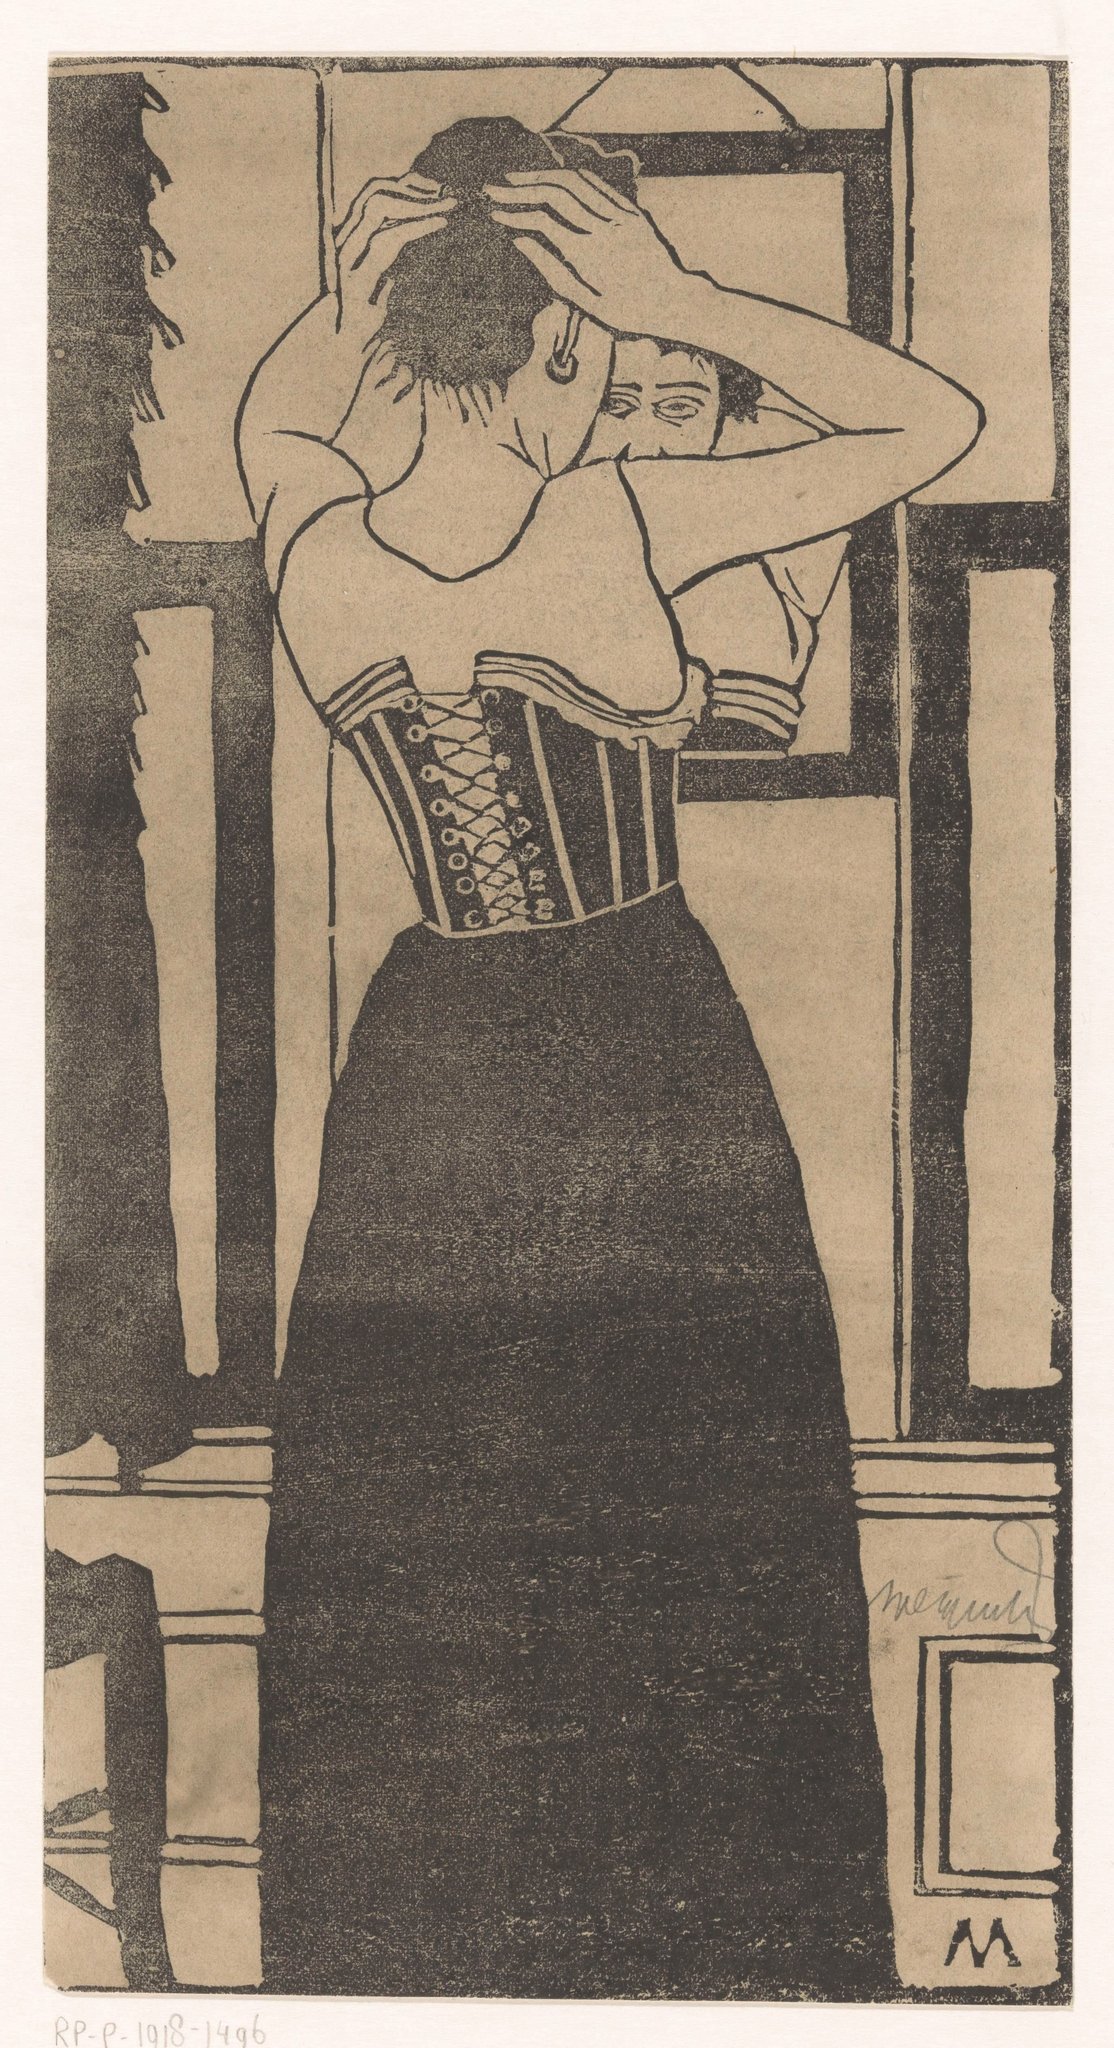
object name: print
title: Voor de spiegel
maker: samuel jessurun de mesquita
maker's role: draughtsman, print maker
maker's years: 1868-1944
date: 1899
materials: paper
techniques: woodcut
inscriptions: signature: ‘H 015’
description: Vrouw in korset op de rug gezien, haar gezicht in de spiegel voor haar.